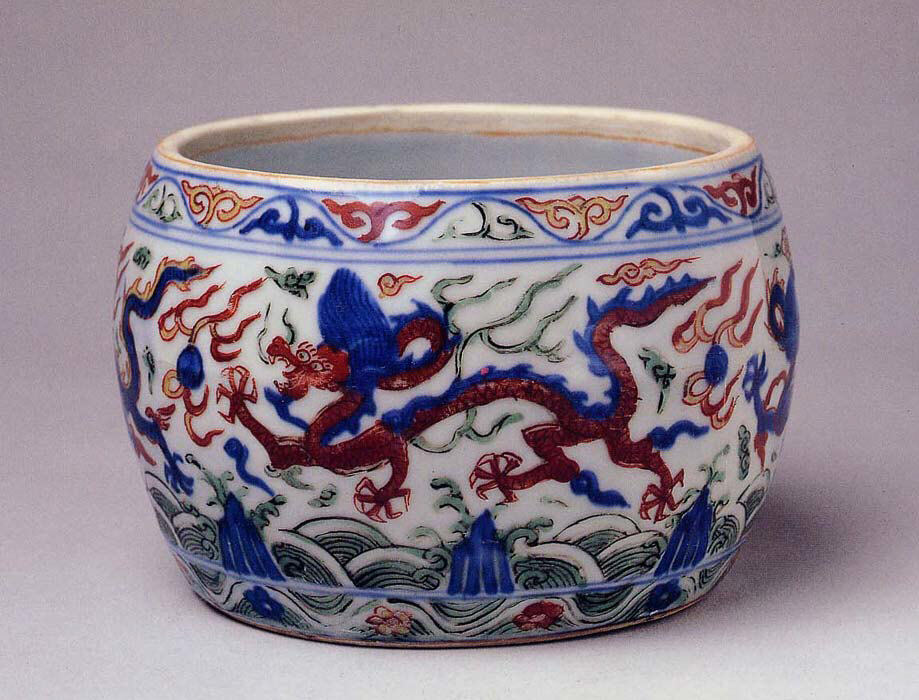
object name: jar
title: Barrel-Shaped Jar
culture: chinese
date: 1573-1621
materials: enamel, porcelain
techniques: overglaze, painting, polychrome, underglaze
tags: dragons